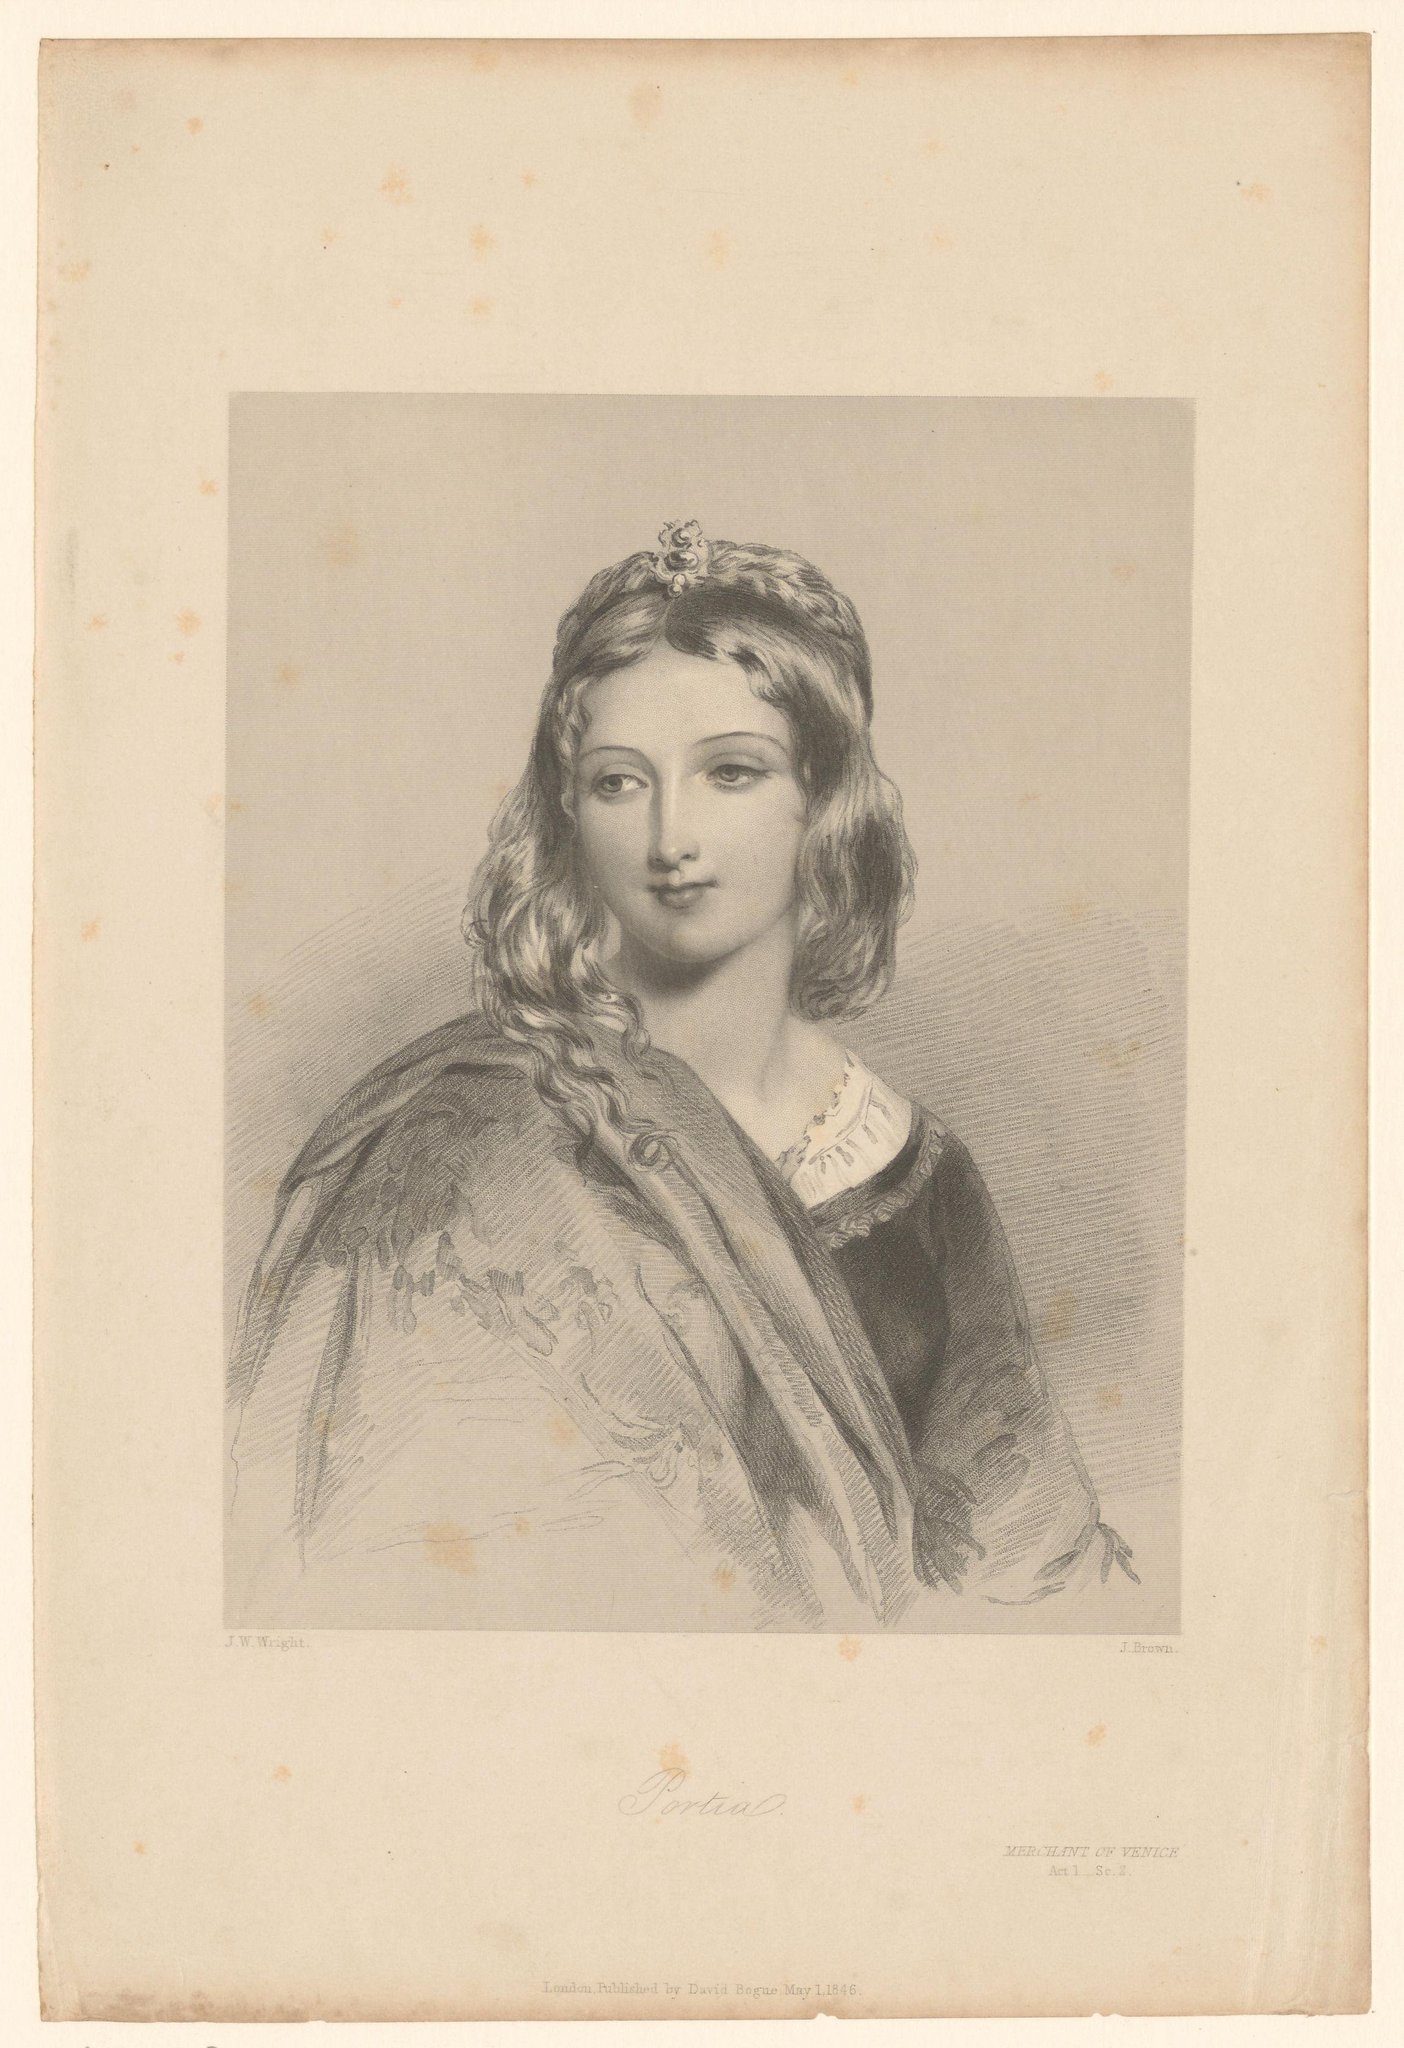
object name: book illustration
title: Portia, naar links kijkend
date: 1805-1846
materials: paper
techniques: printmaking, etching, engraving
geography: london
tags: head (human) - aa - female human figure, female literary characters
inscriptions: collector's mark: Lugt 2228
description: Prent ook gebruikt in: Heath, Charles. The heroines of Shakespeare: comprising the principal female characters in the plays of the great poet. Londen: David Bogue, 1848.